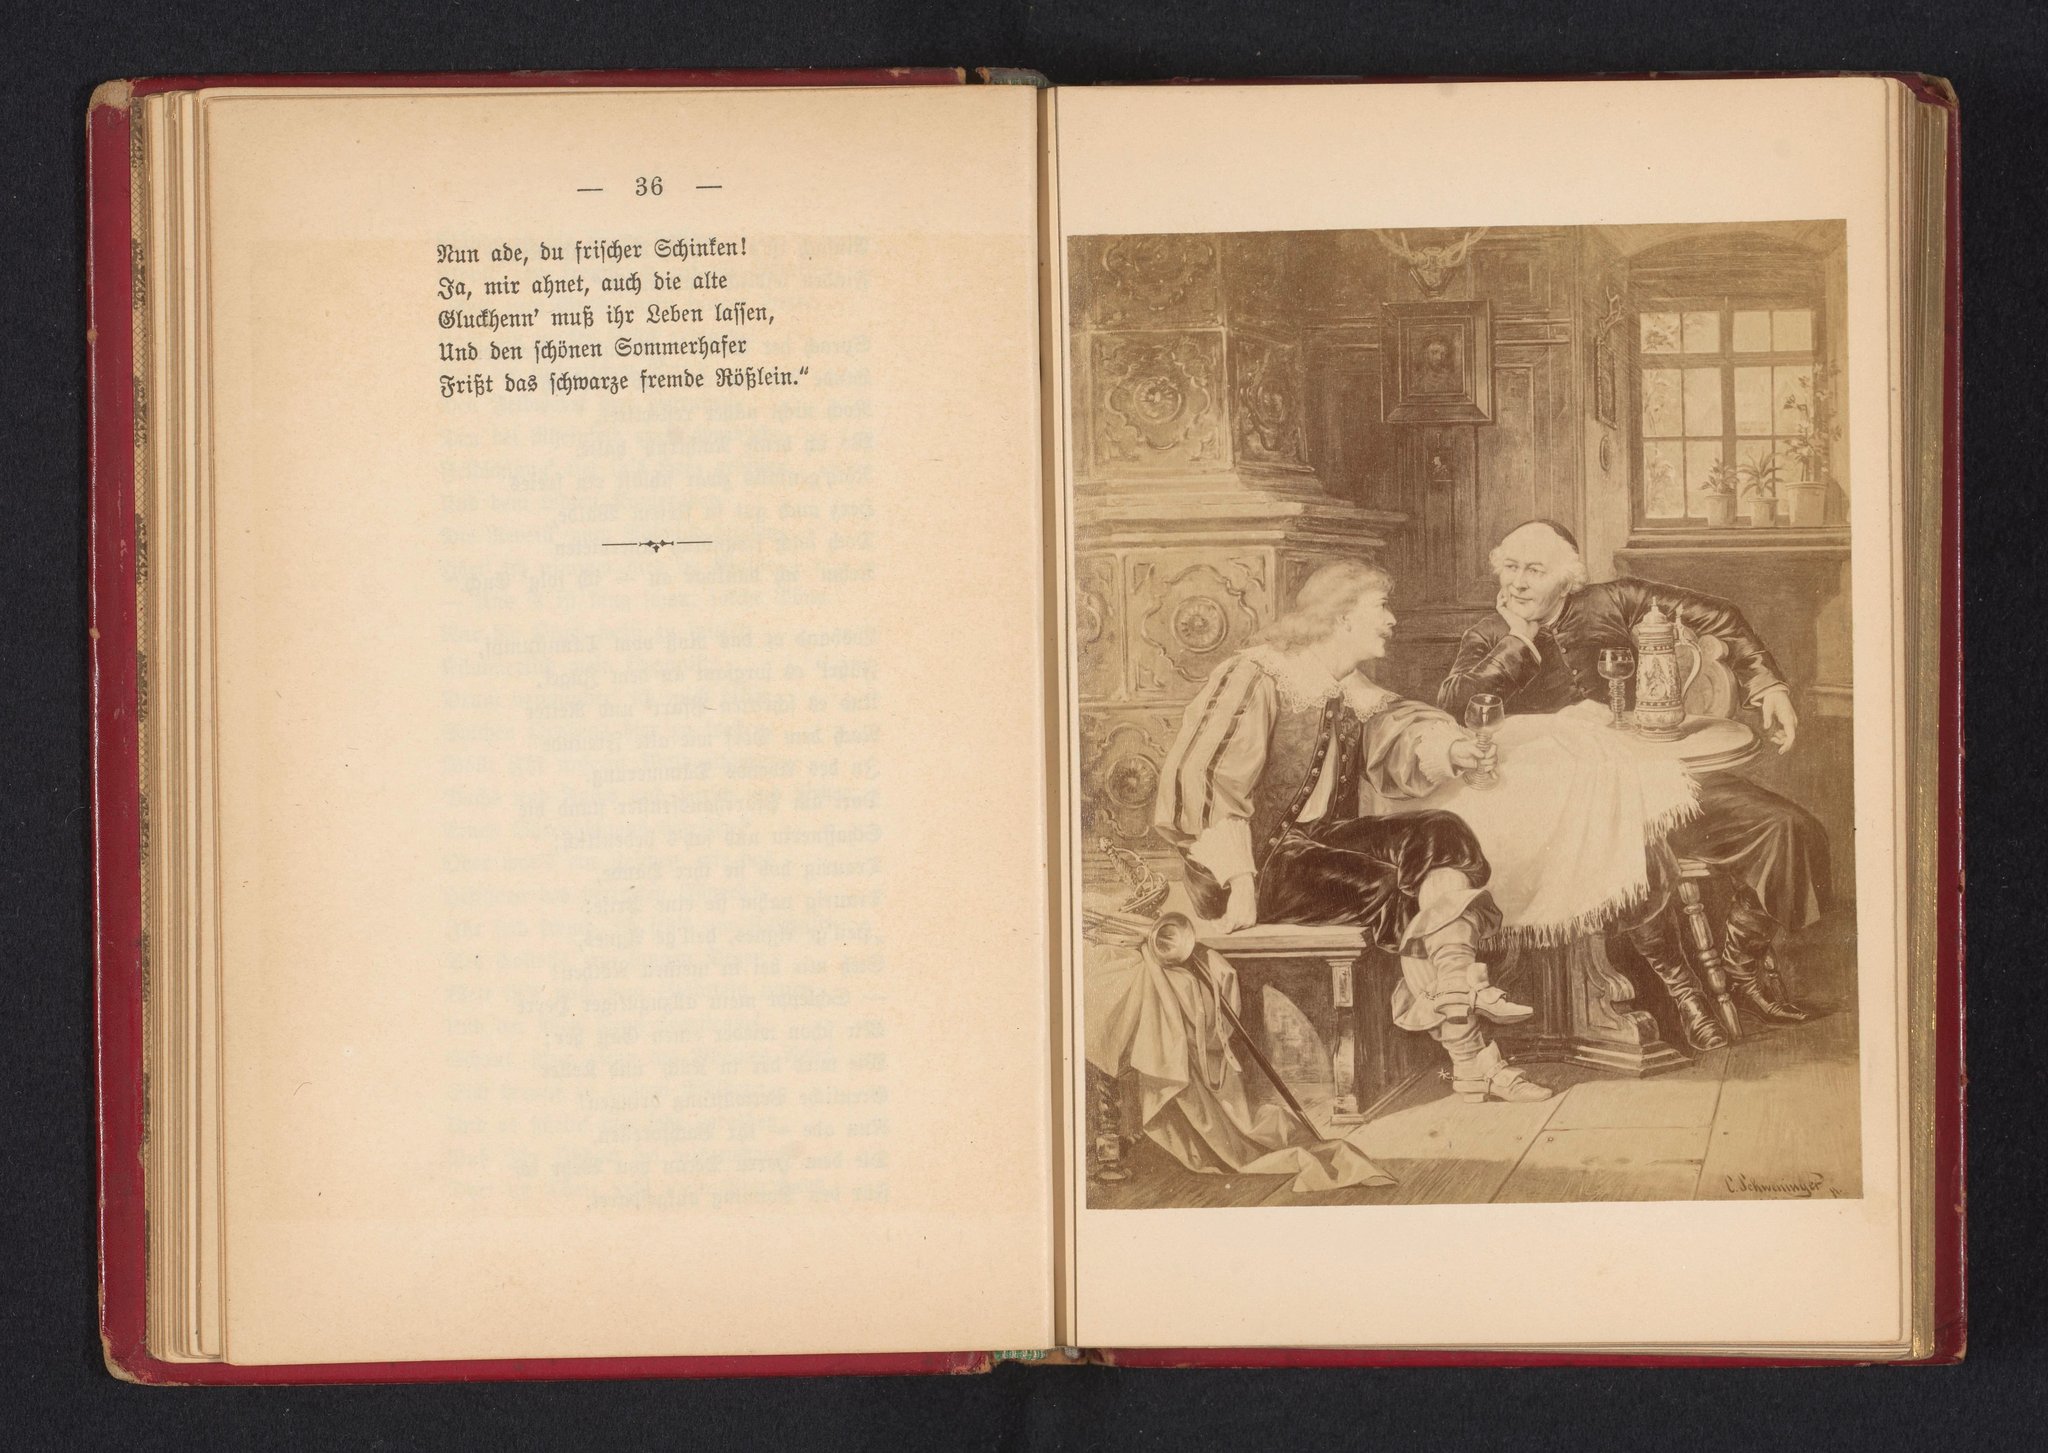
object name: page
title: Fotoreproductie van een schilderij van een scene uit Der Trompeter von Säkkingen, voorstellende de trompetter drinkend met een andere man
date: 1880-1890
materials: photographic support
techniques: albumen print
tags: picture, painting, drinking